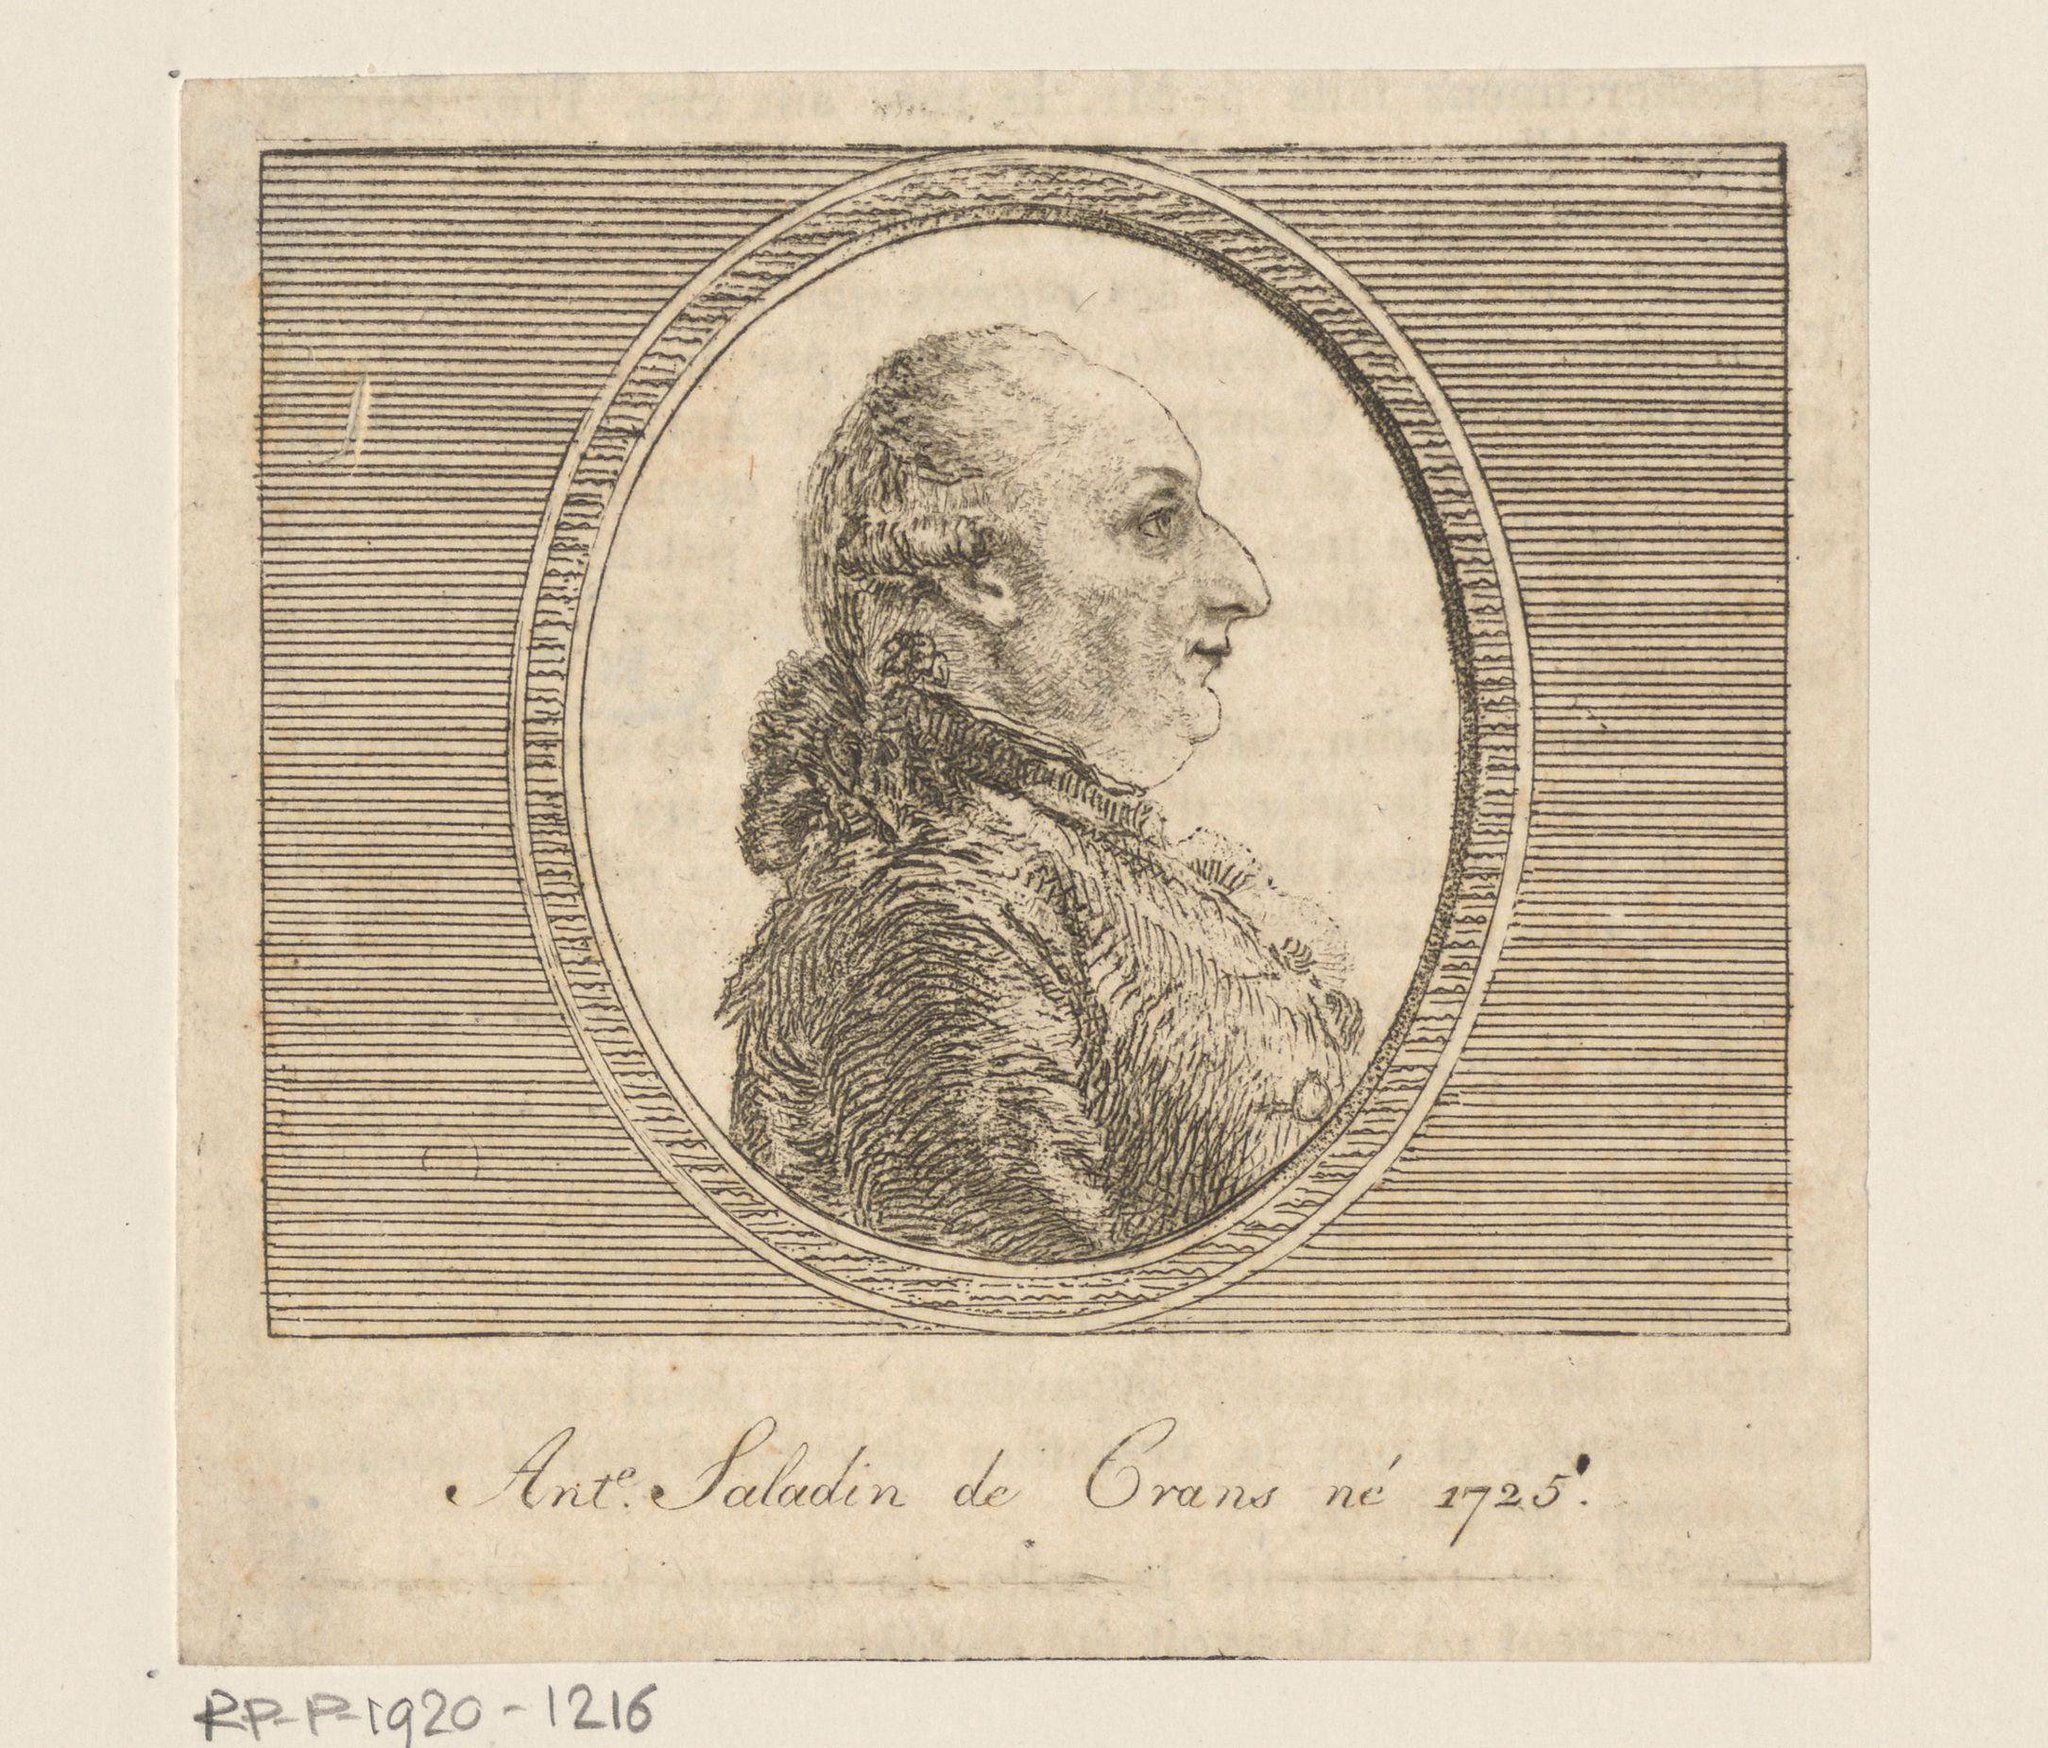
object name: book illustration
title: Portret van Antoine Saladin de Crans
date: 1815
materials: paper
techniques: etching, letterpress printing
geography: geneva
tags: historical persons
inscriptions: collector's mark: Lugt 2228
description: Prent uit: Fragmens biographiques et historiques (...). Genève: Magnet en Abraham Cherbuliez, 1815.